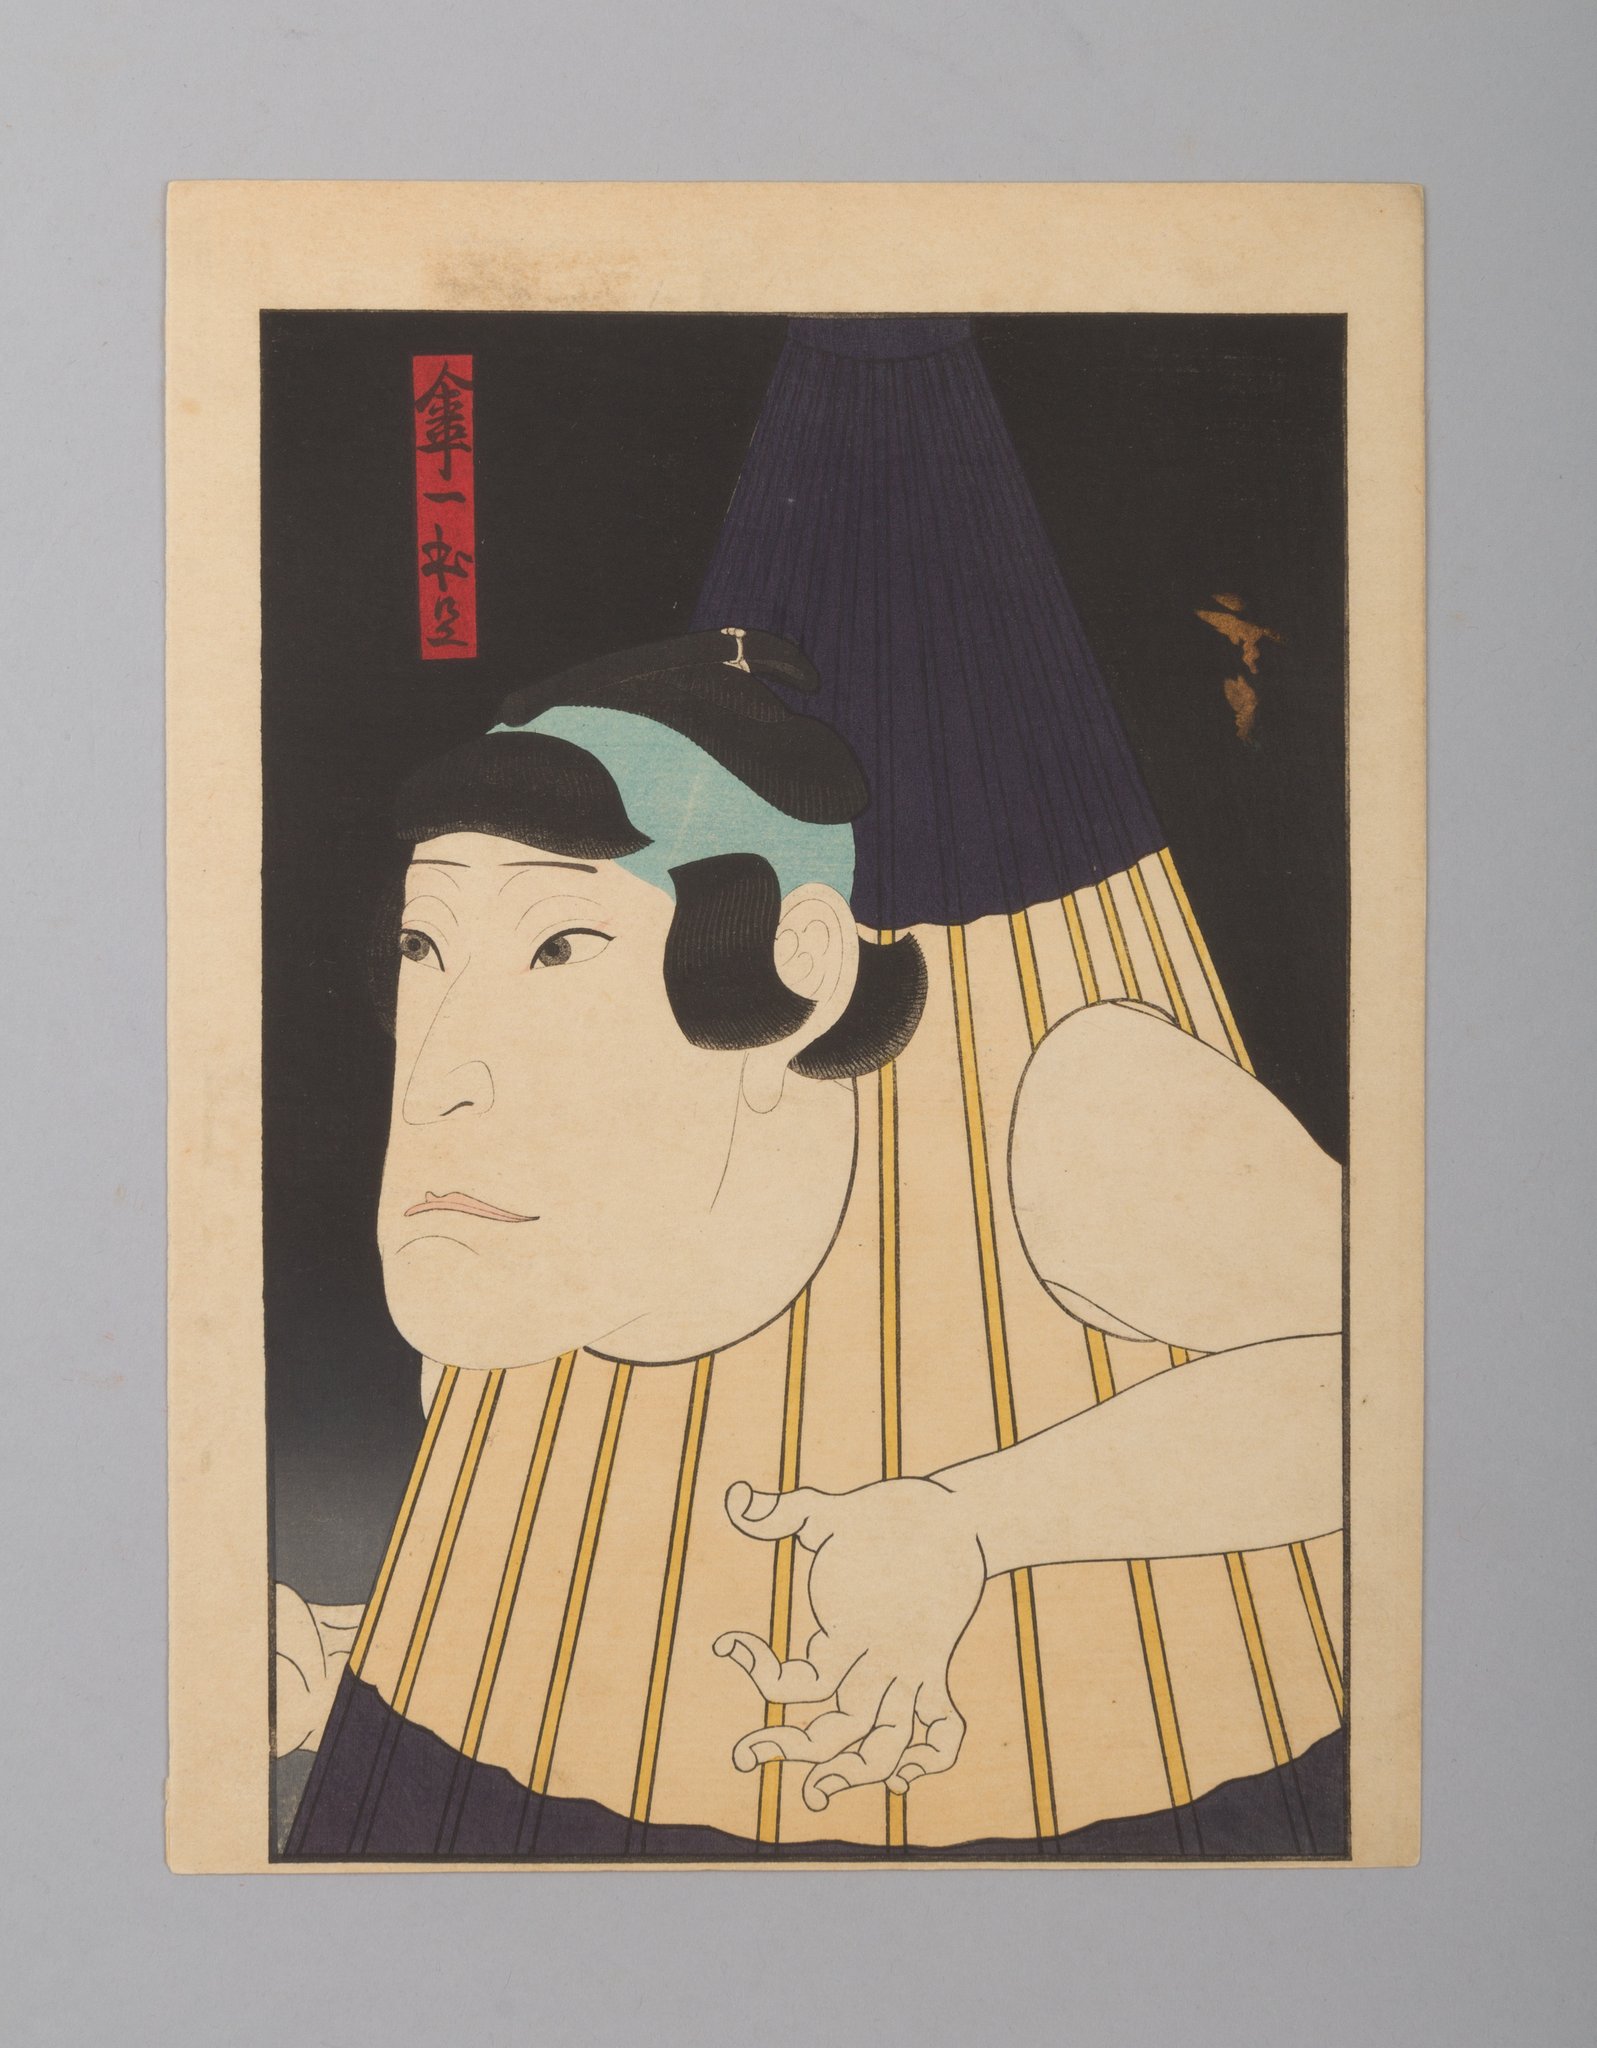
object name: woodblock print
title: “One-Legged Umbrella Monster” (Kasa ippon ashi)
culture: japanese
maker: gosōtei hirosada 五粽亭広貞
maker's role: artist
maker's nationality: japanese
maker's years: 1819-1863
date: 1857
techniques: nishiki e, woodblock print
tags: men,actors,umbrellas